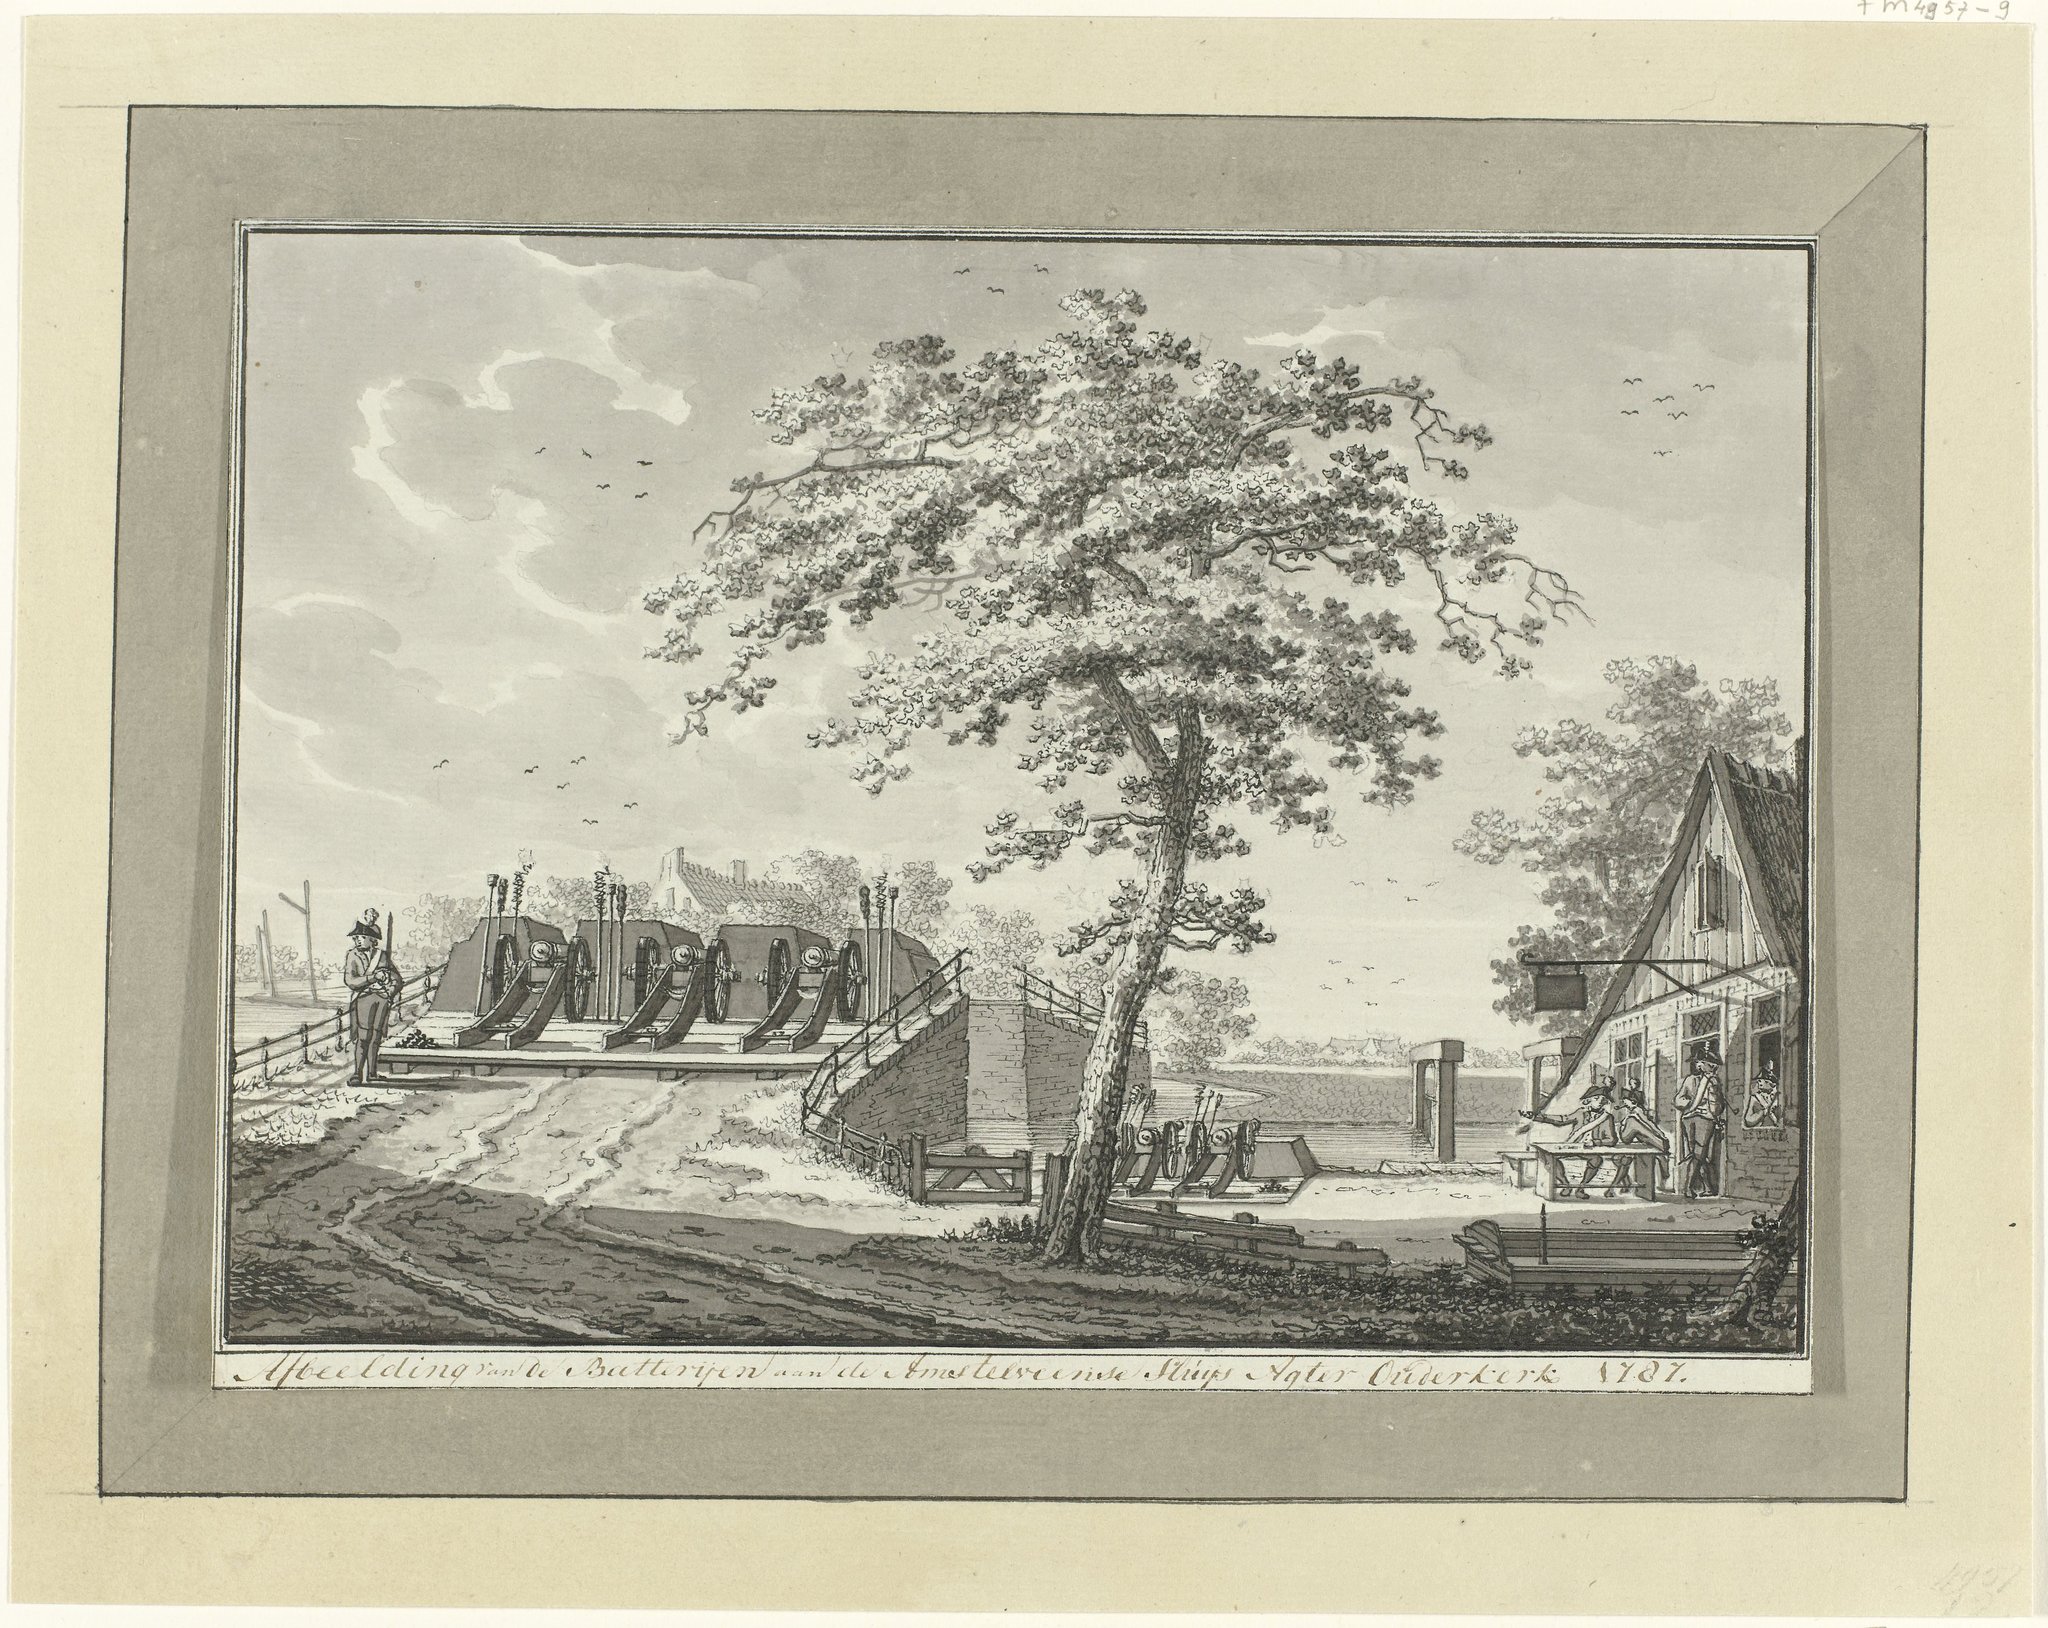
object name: drawing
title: Afbeelding van de Batterijen aan de Amstelveense Sluijs Agter Ouderkerk 1787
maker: Anonymous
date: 1787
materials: paper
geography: northern netherlands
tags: defence of fortification or city, defensive measures (military)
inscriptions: collector's mark: Lugt 2228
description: Battterij aan de sluis te Ouderkerk aan de Amstel. Onderdeel van een groep van tien tekeningen van de verdedigingen aangelegd door de patriotten rondom Amsterdam ten tijde van de inval van de Pruisische troepen in september 1787.